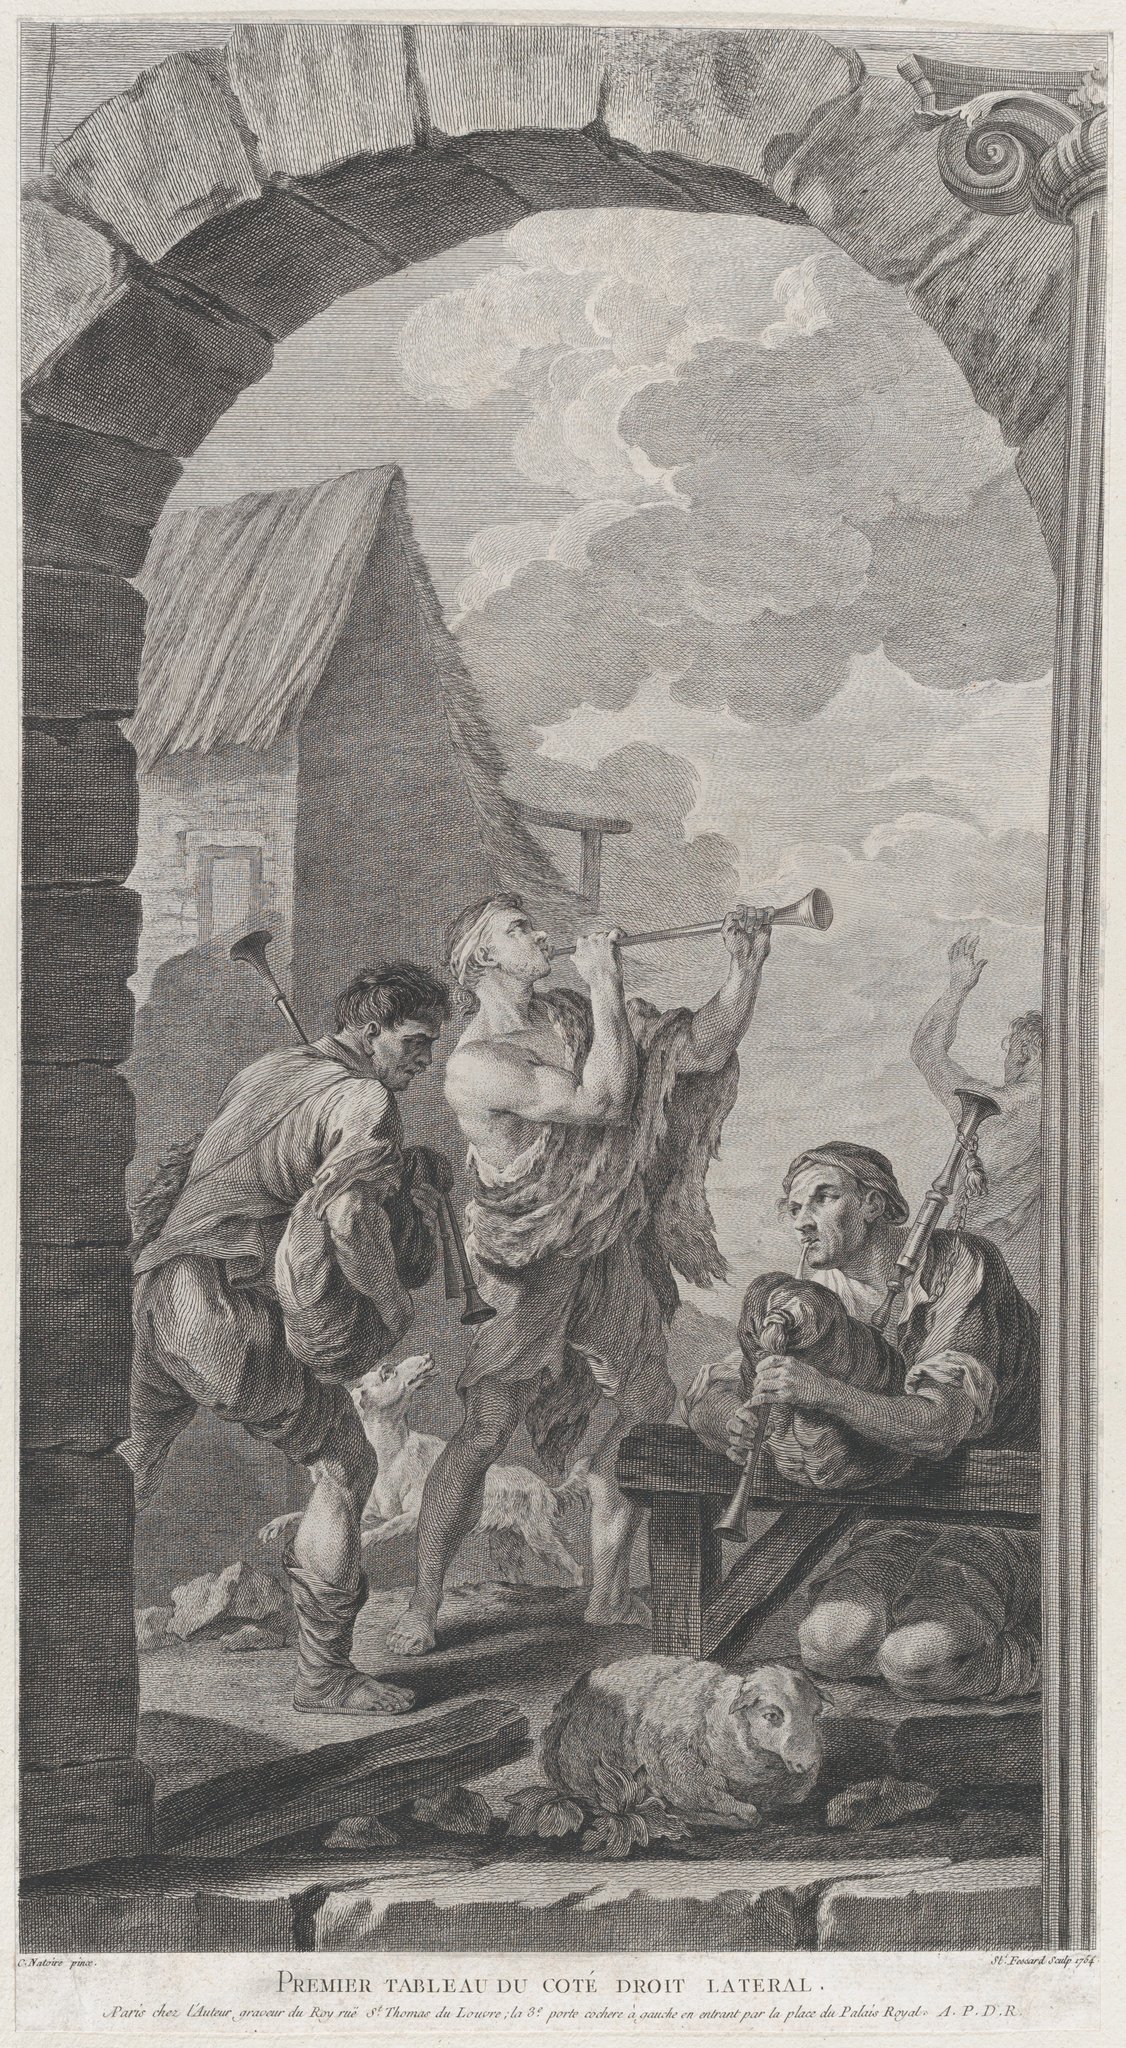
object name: print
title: The Chapel of the Enfants-Trouvés in Paris: Groupe des bergers: joueurs de trompes et de musette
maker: etienne fessard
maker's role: artist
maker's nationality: french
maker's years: 1714-1777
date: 1754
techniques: engraving, etching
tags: men,bagpipes,dogs,sheep